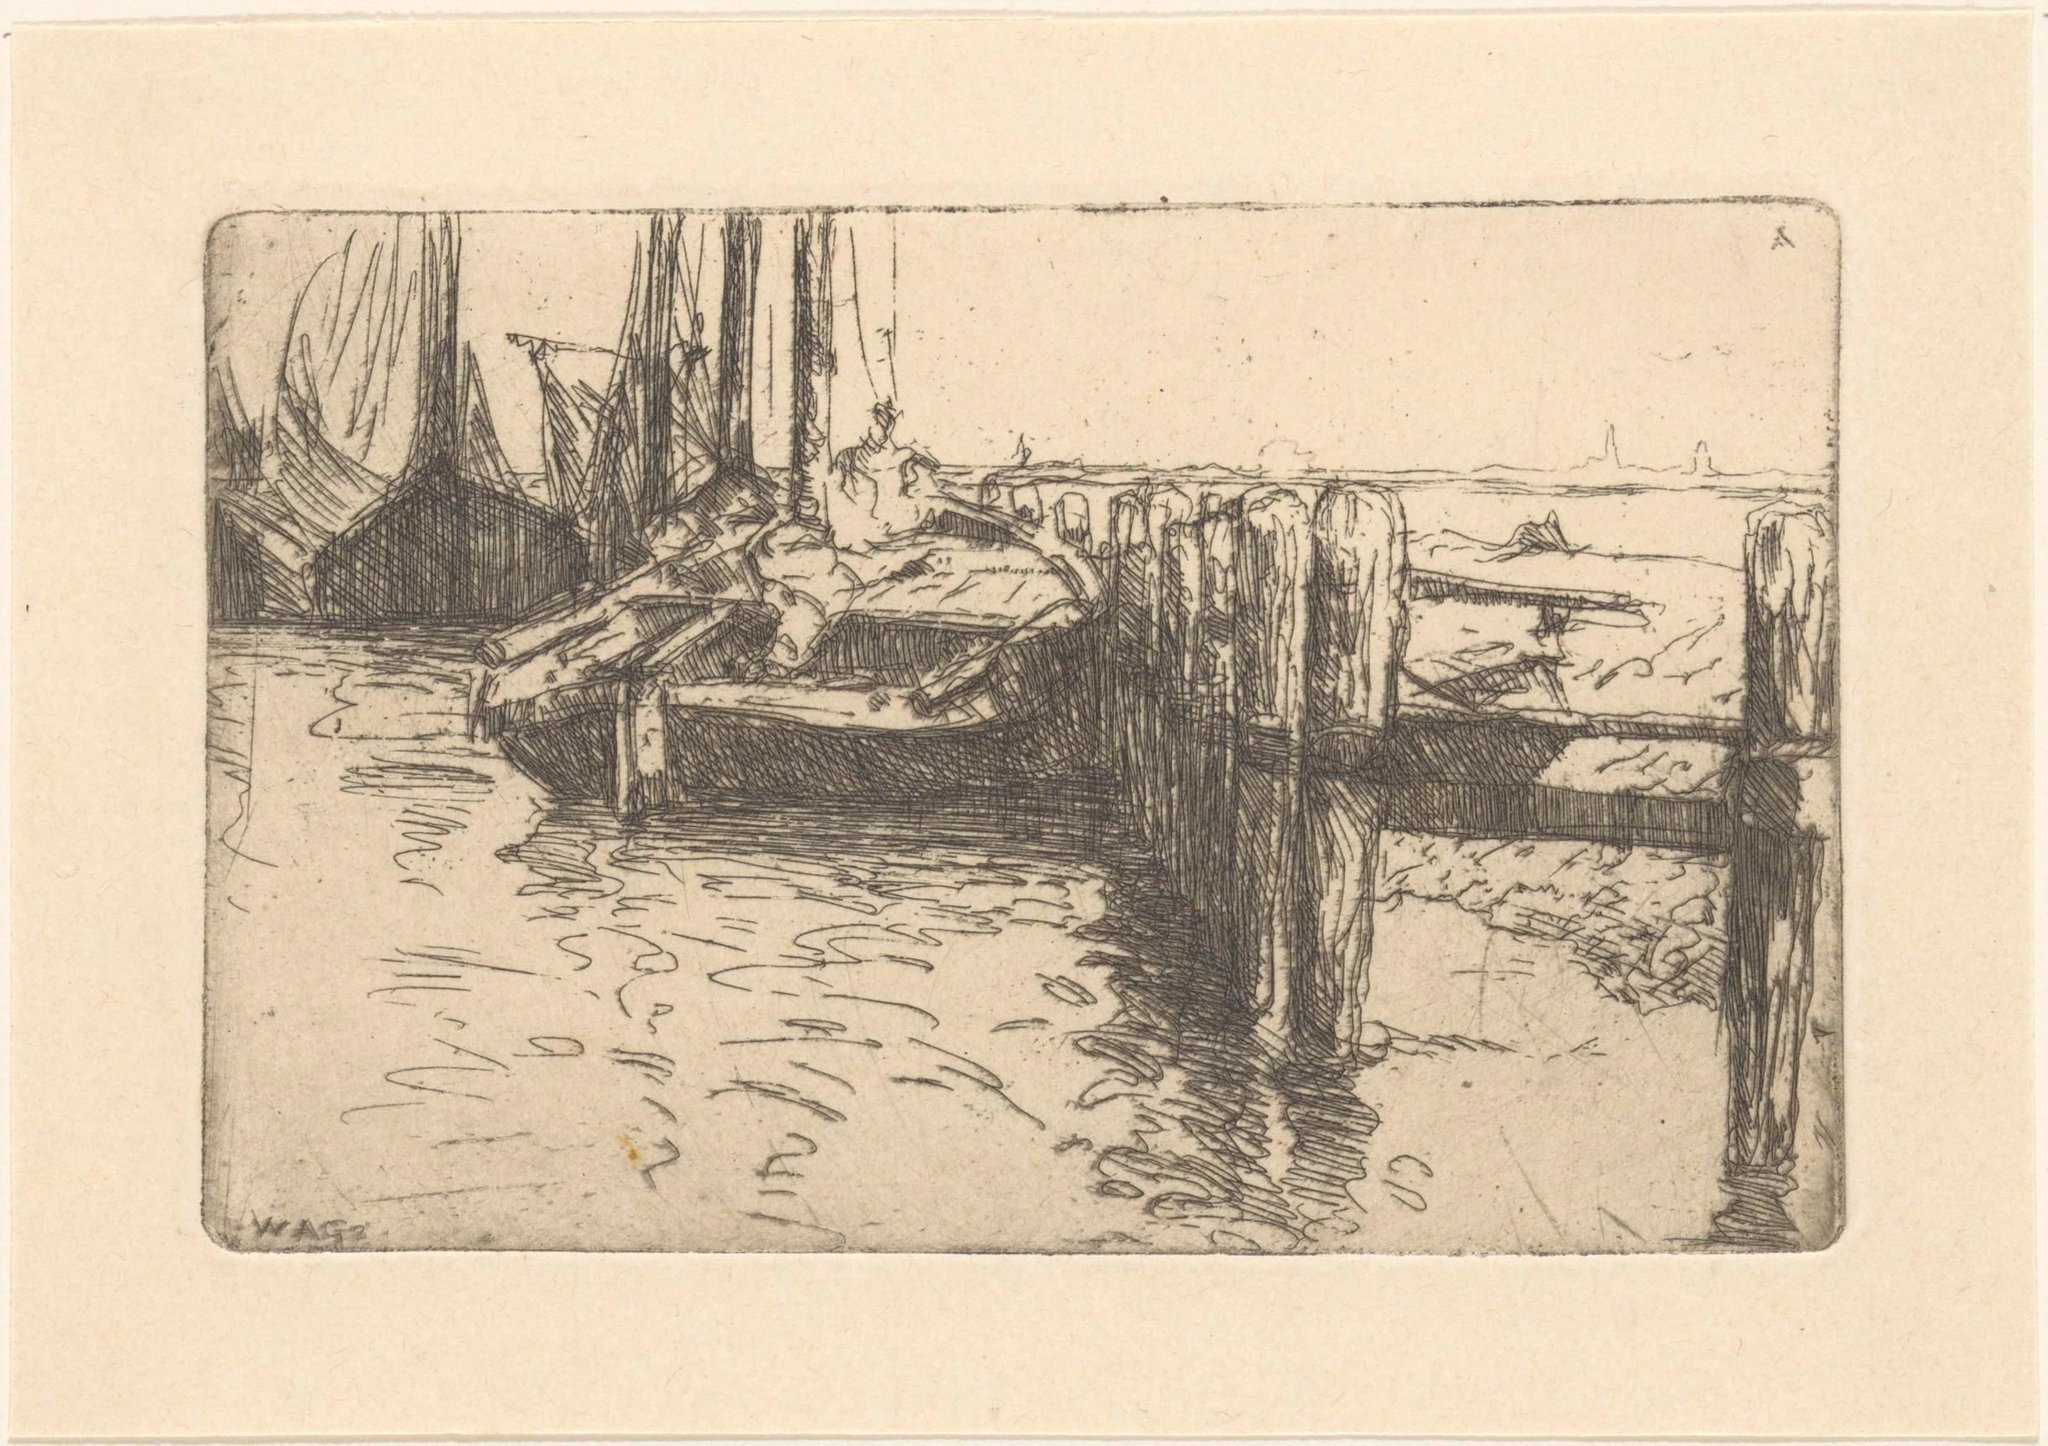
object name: print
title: Afgemeerde schuiten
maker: willem adrianus grondhout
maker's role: draughtsman, painter, print maker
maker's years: 1878-1934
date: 1888-1931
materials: paper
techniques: etching, intaglio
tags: harbour